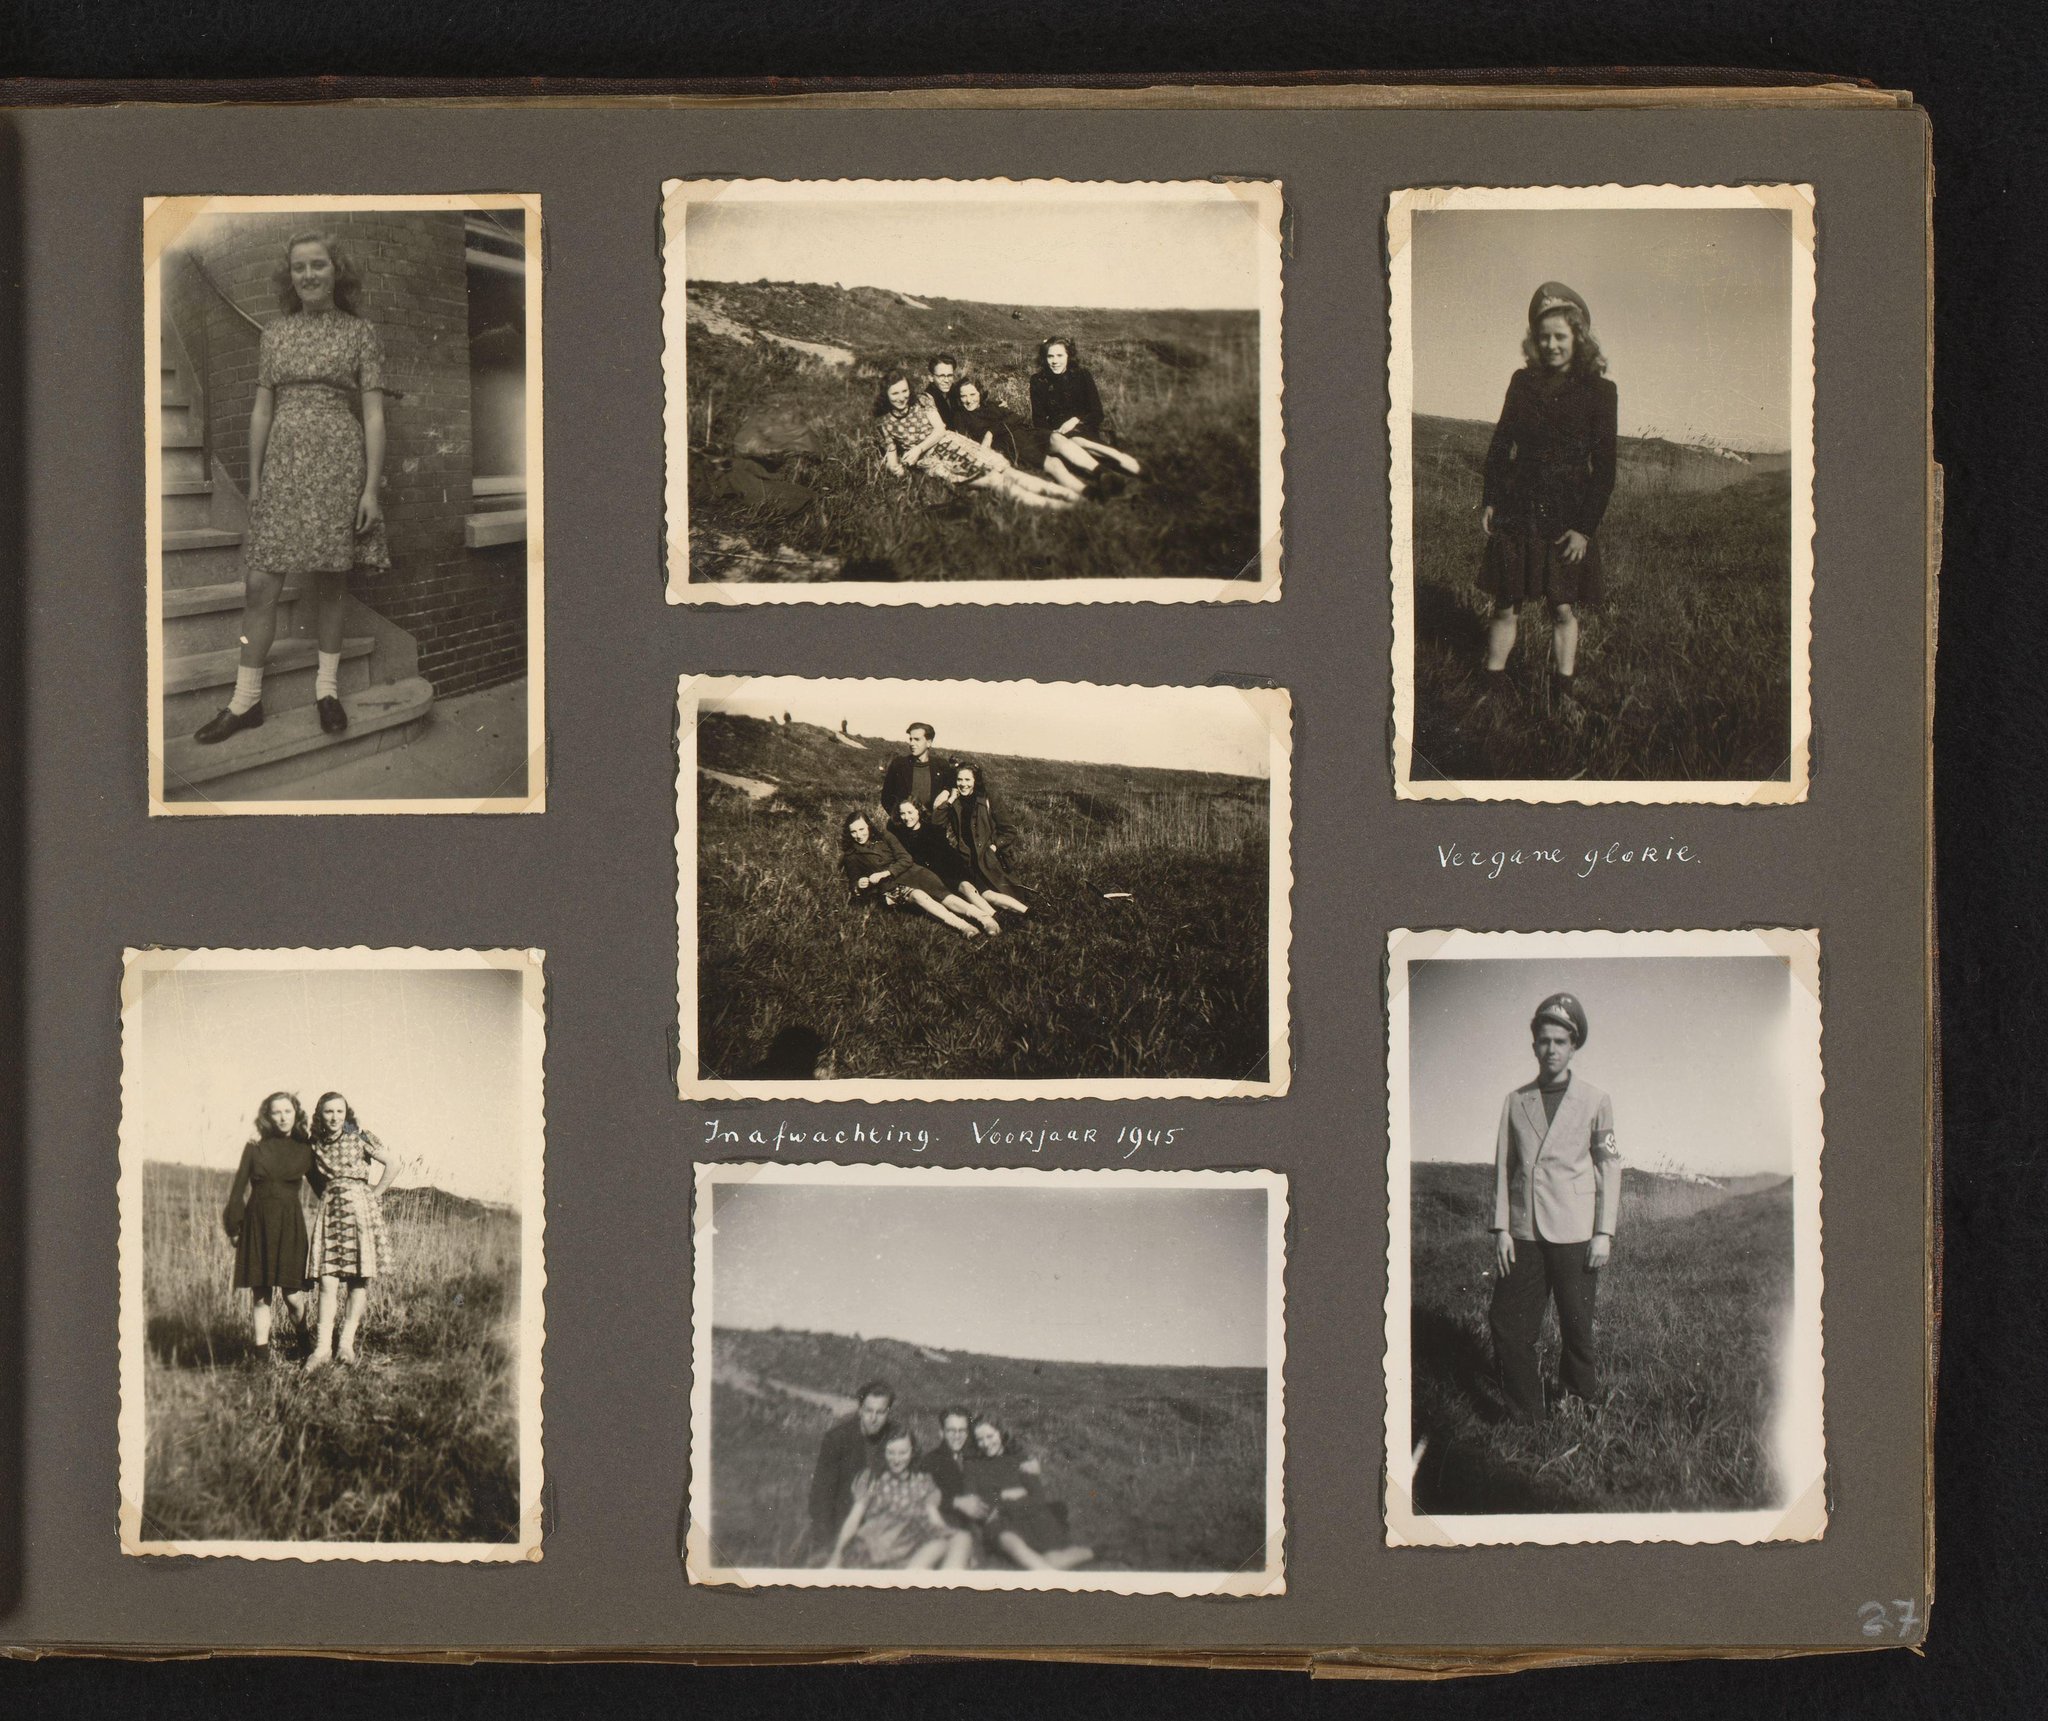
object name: photograph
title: Voorjaar 1945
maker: Anonymous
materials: paper, photographic support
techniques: gelatin silver print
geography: the hague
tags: recreation, (military) uniforms, the hague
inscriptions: inscription: ‘In afwachting. Voorjaar 1945 / Vergane glorie.’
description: Albumblad met zeven foto's uit het voorjaar van 1945. De meeste met de samenstelster van het album samen met vrienden. Op twee foto's poseren een vriendin en vriend met een Duitse officierspet en een armband met hakenkruis. Hierbij het opschrift 'Vergane glorie'.